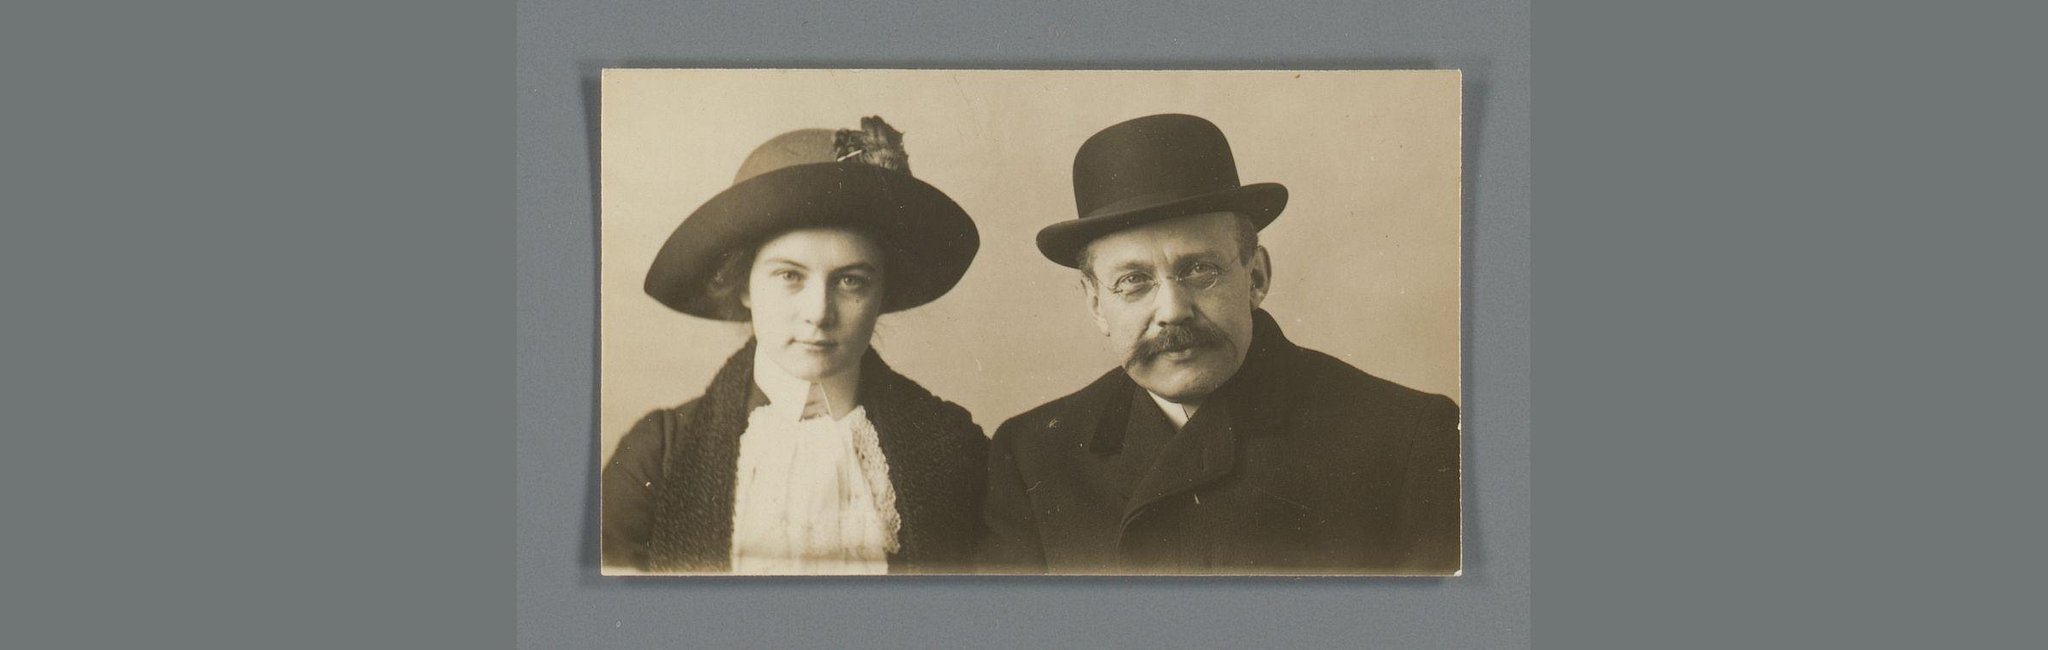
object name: photograph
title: Portret van Johanna (Hans) de Jong en Willem de Jong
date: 1912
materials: paper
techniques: gelatin silver print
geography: the hague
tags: johanna petronella lambertina stokhuyzen-de jong (hans), willem de jong (fotograaf), historical persons